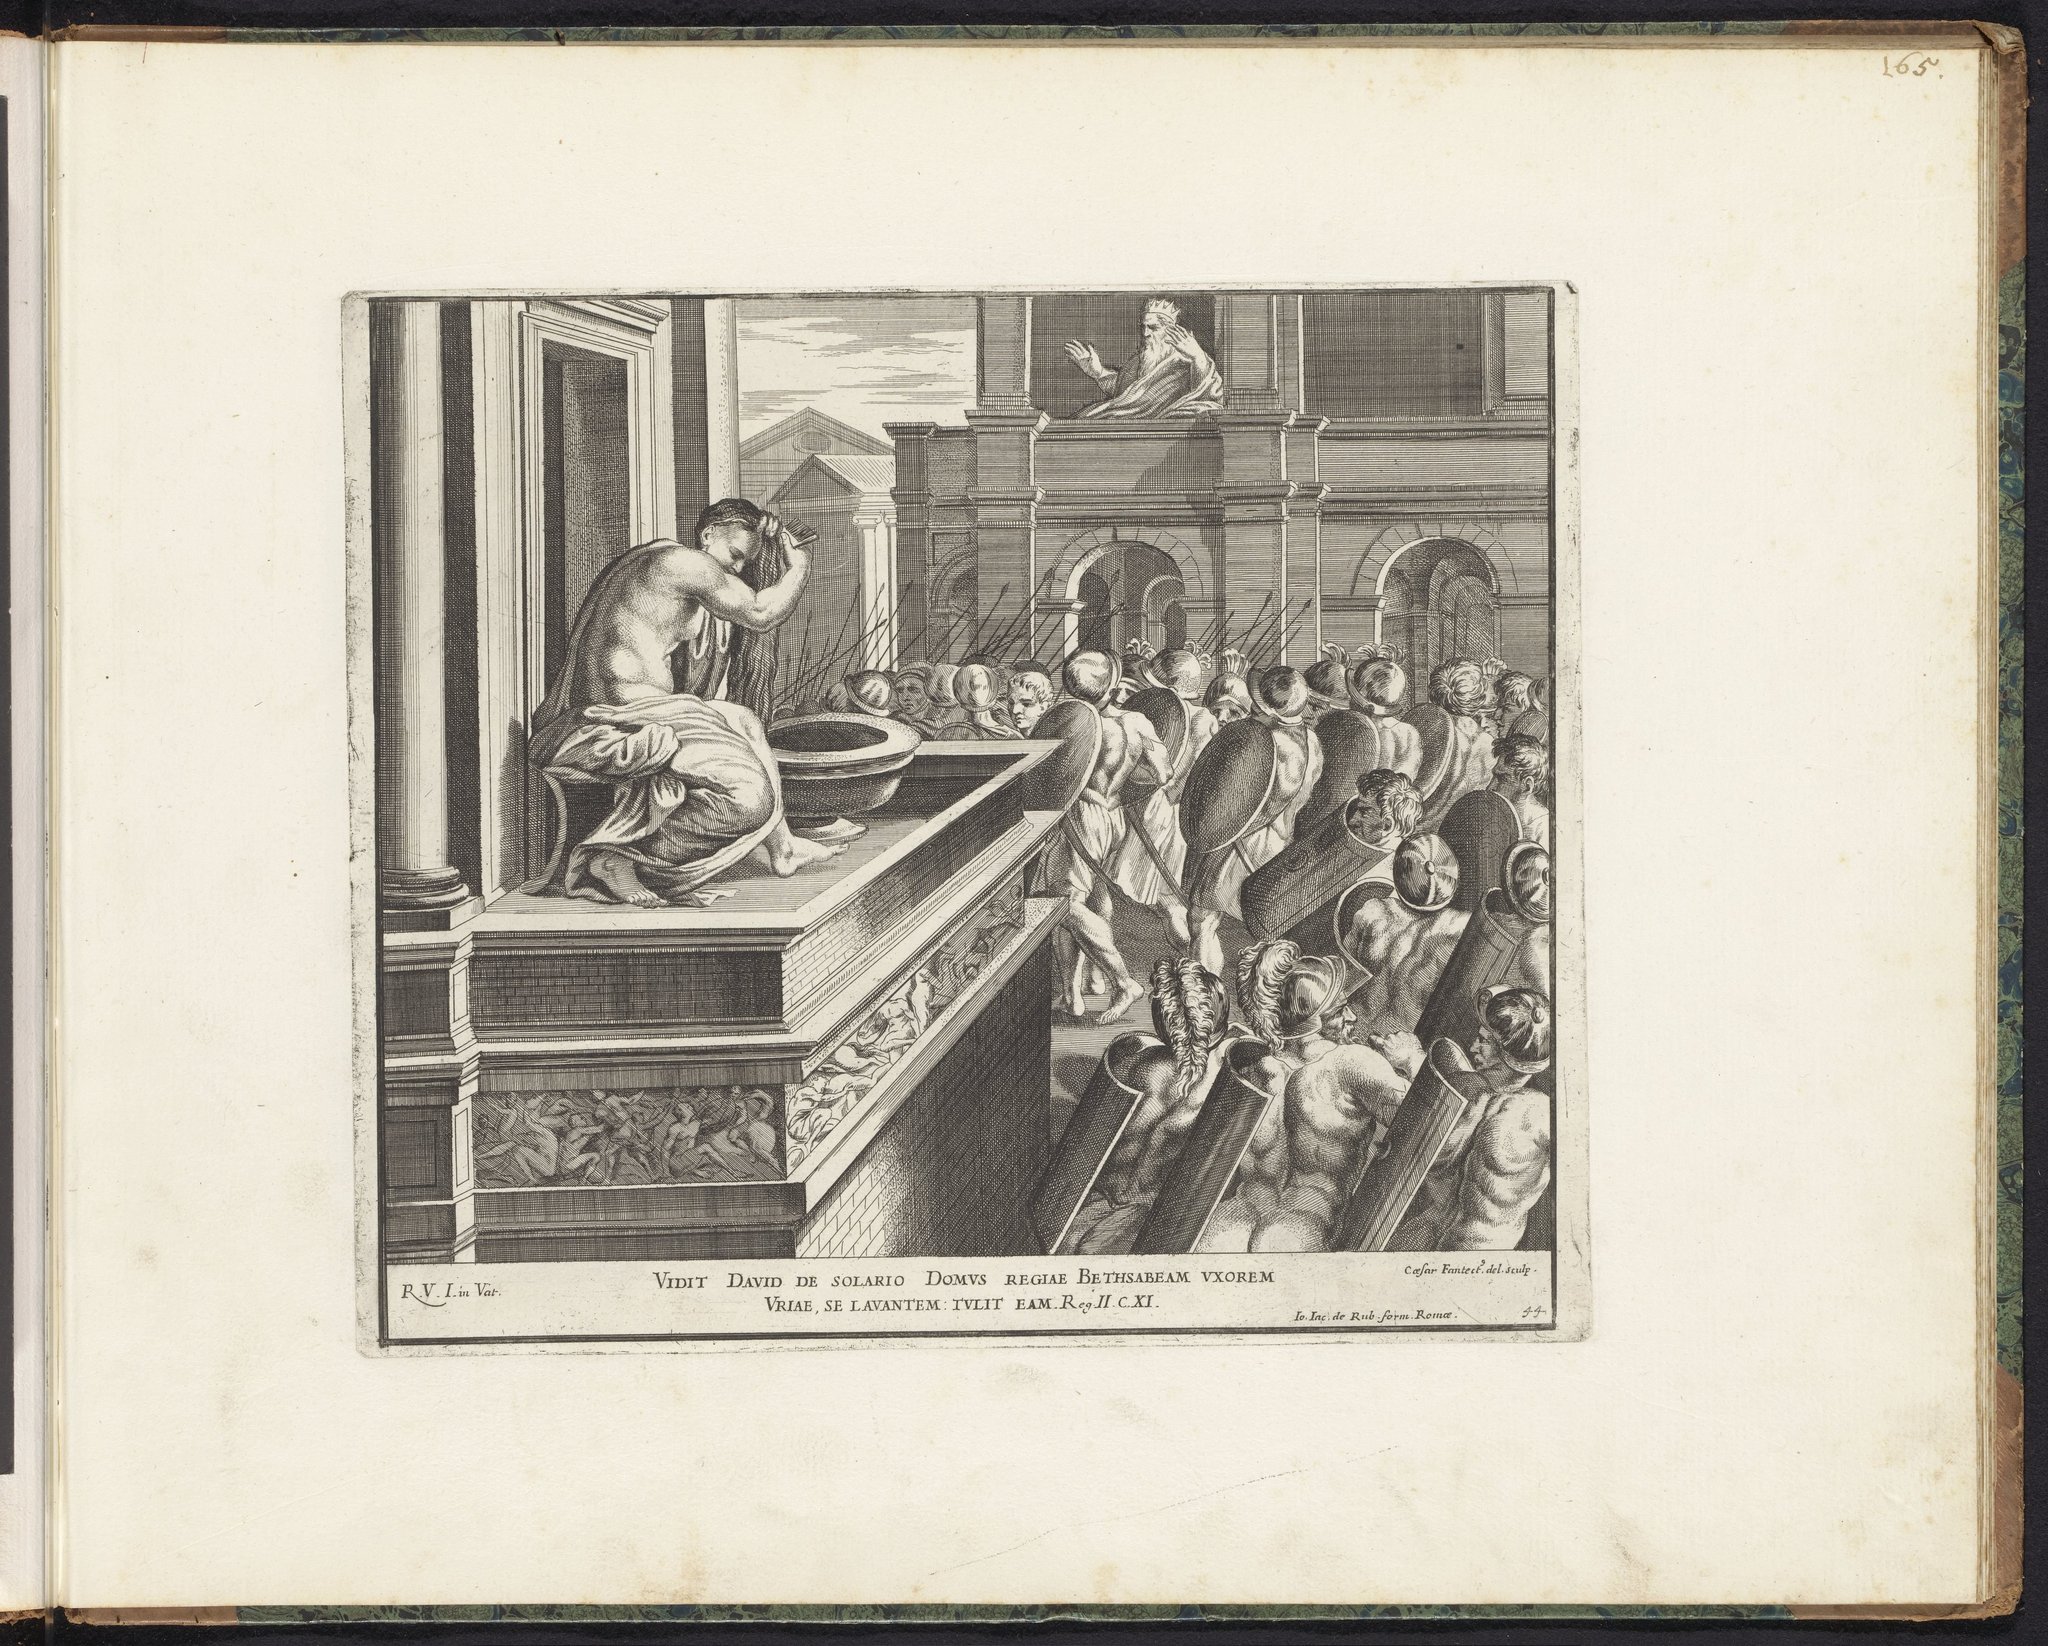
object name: print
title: Schilderingen in de Loggia van Rafaël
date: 1675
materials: paper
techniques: etching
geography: vatican city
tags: david, from the roof (or balcony) of his palace, sees bathsheba bathing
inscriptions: number: ‘165’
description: De naakte Batseba baadt zich. Koning David bespiedt haar vanuit zijn paleis. Over straat loopt een menigte soldaten. Bijbelvers onder de voorstelling. Prent maakt deel uit van een album.